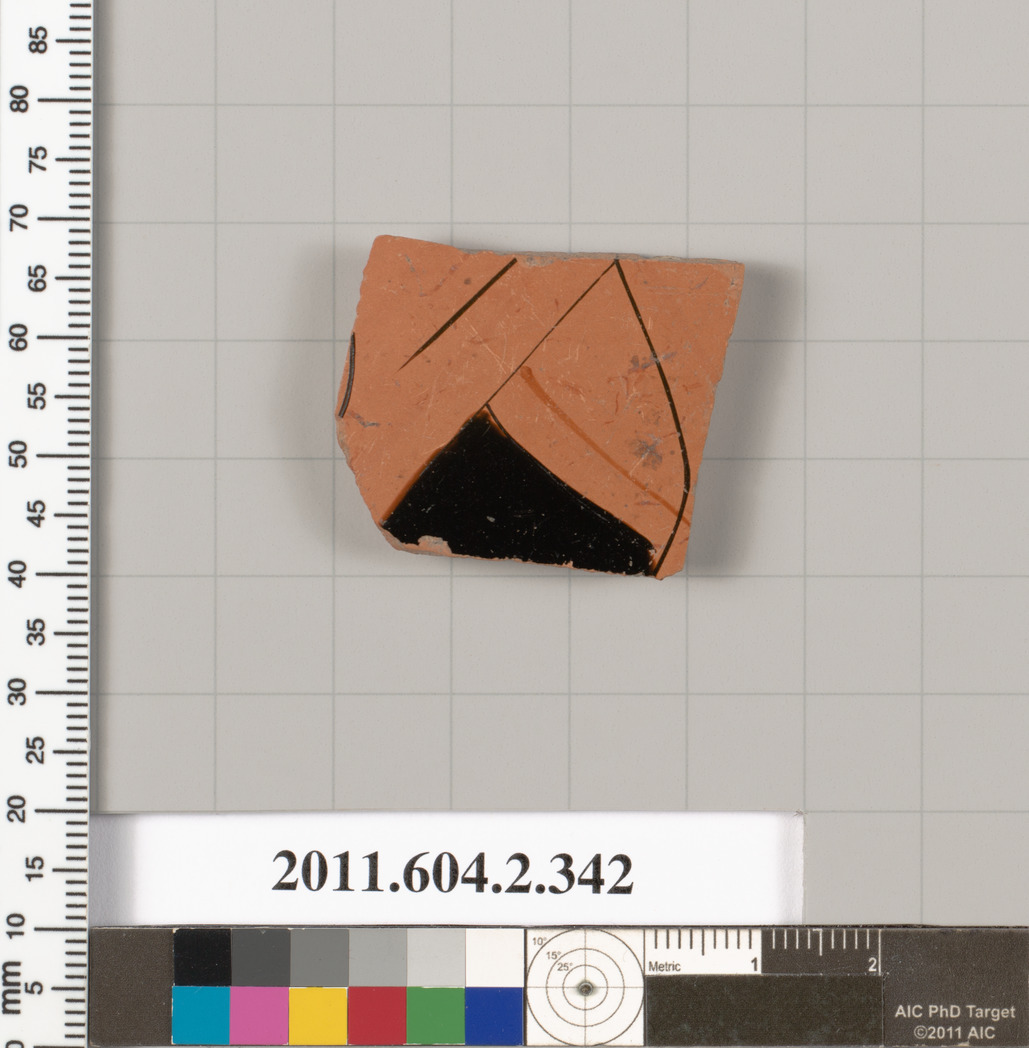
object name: column krater fragment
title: Terracotta fragment of a column-krater (bowl for mixing wine and water)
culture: greek, attic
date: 460-440 BCE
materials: terracotta